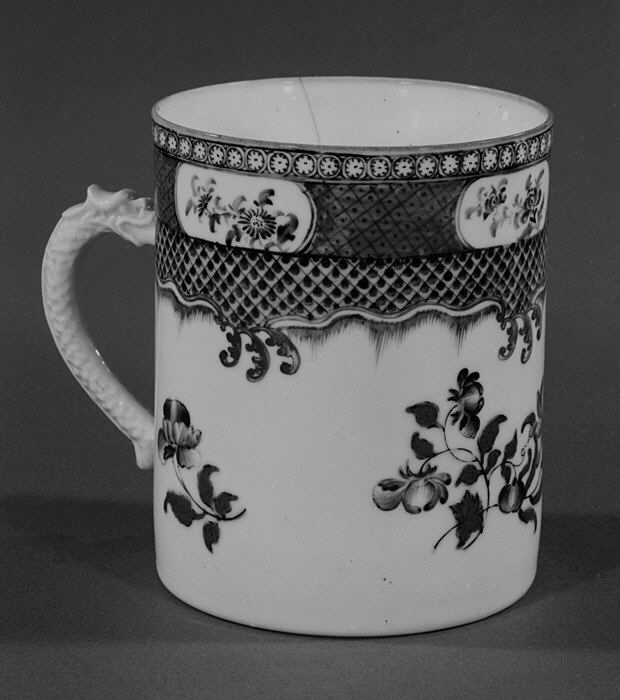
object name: mug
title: Mug (one of two)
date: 1775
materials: hard paste porcelain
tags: flowers